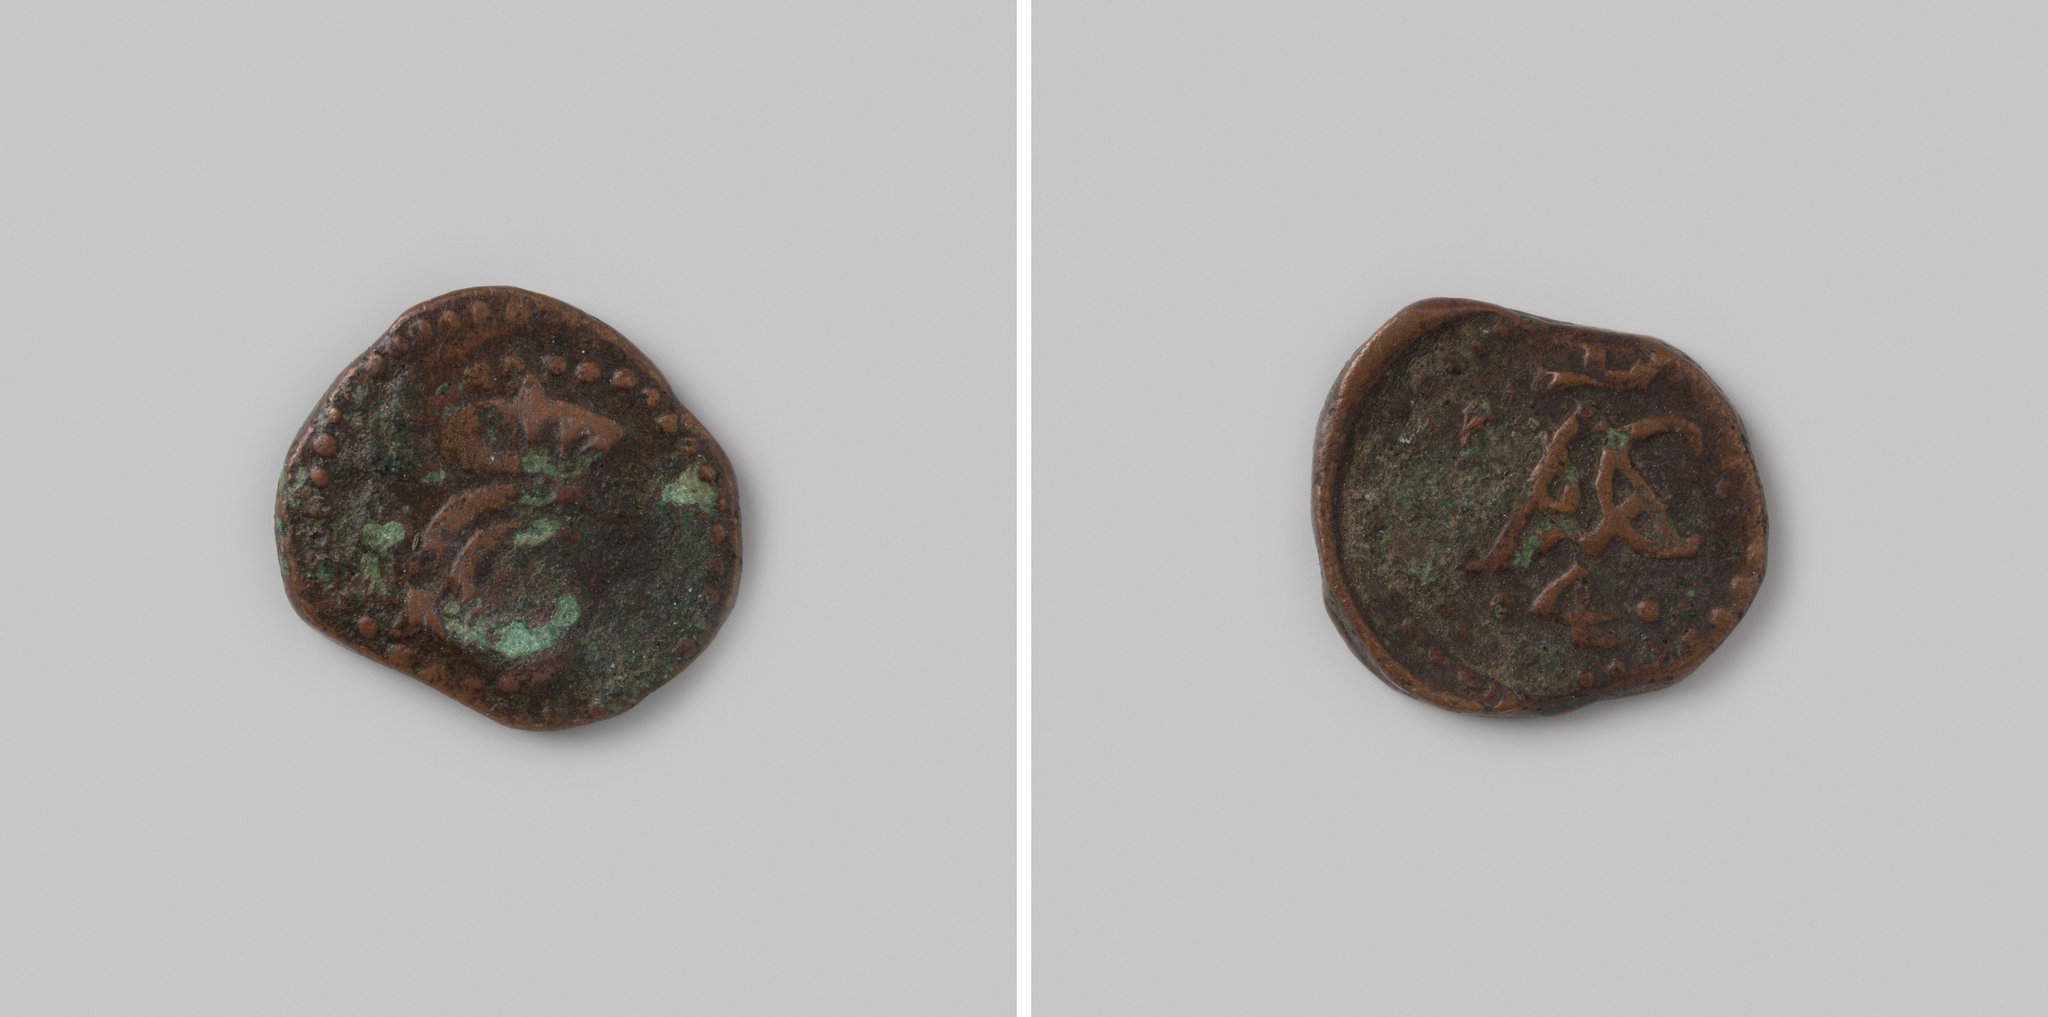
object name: coin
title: 4 kas uit Tranquebar, Deens-India van de Deense Aziatische Compagnie (DAC) op naam van koning Christiaan VI, 1730-1746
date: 1730-1746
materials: copper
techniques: striking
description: Koperen munt. Voorzijde: gekroond monogram van de koning. Keerzijde: gekroond monogram van de DAC. Daaronder waarde-aanduiding: 4.